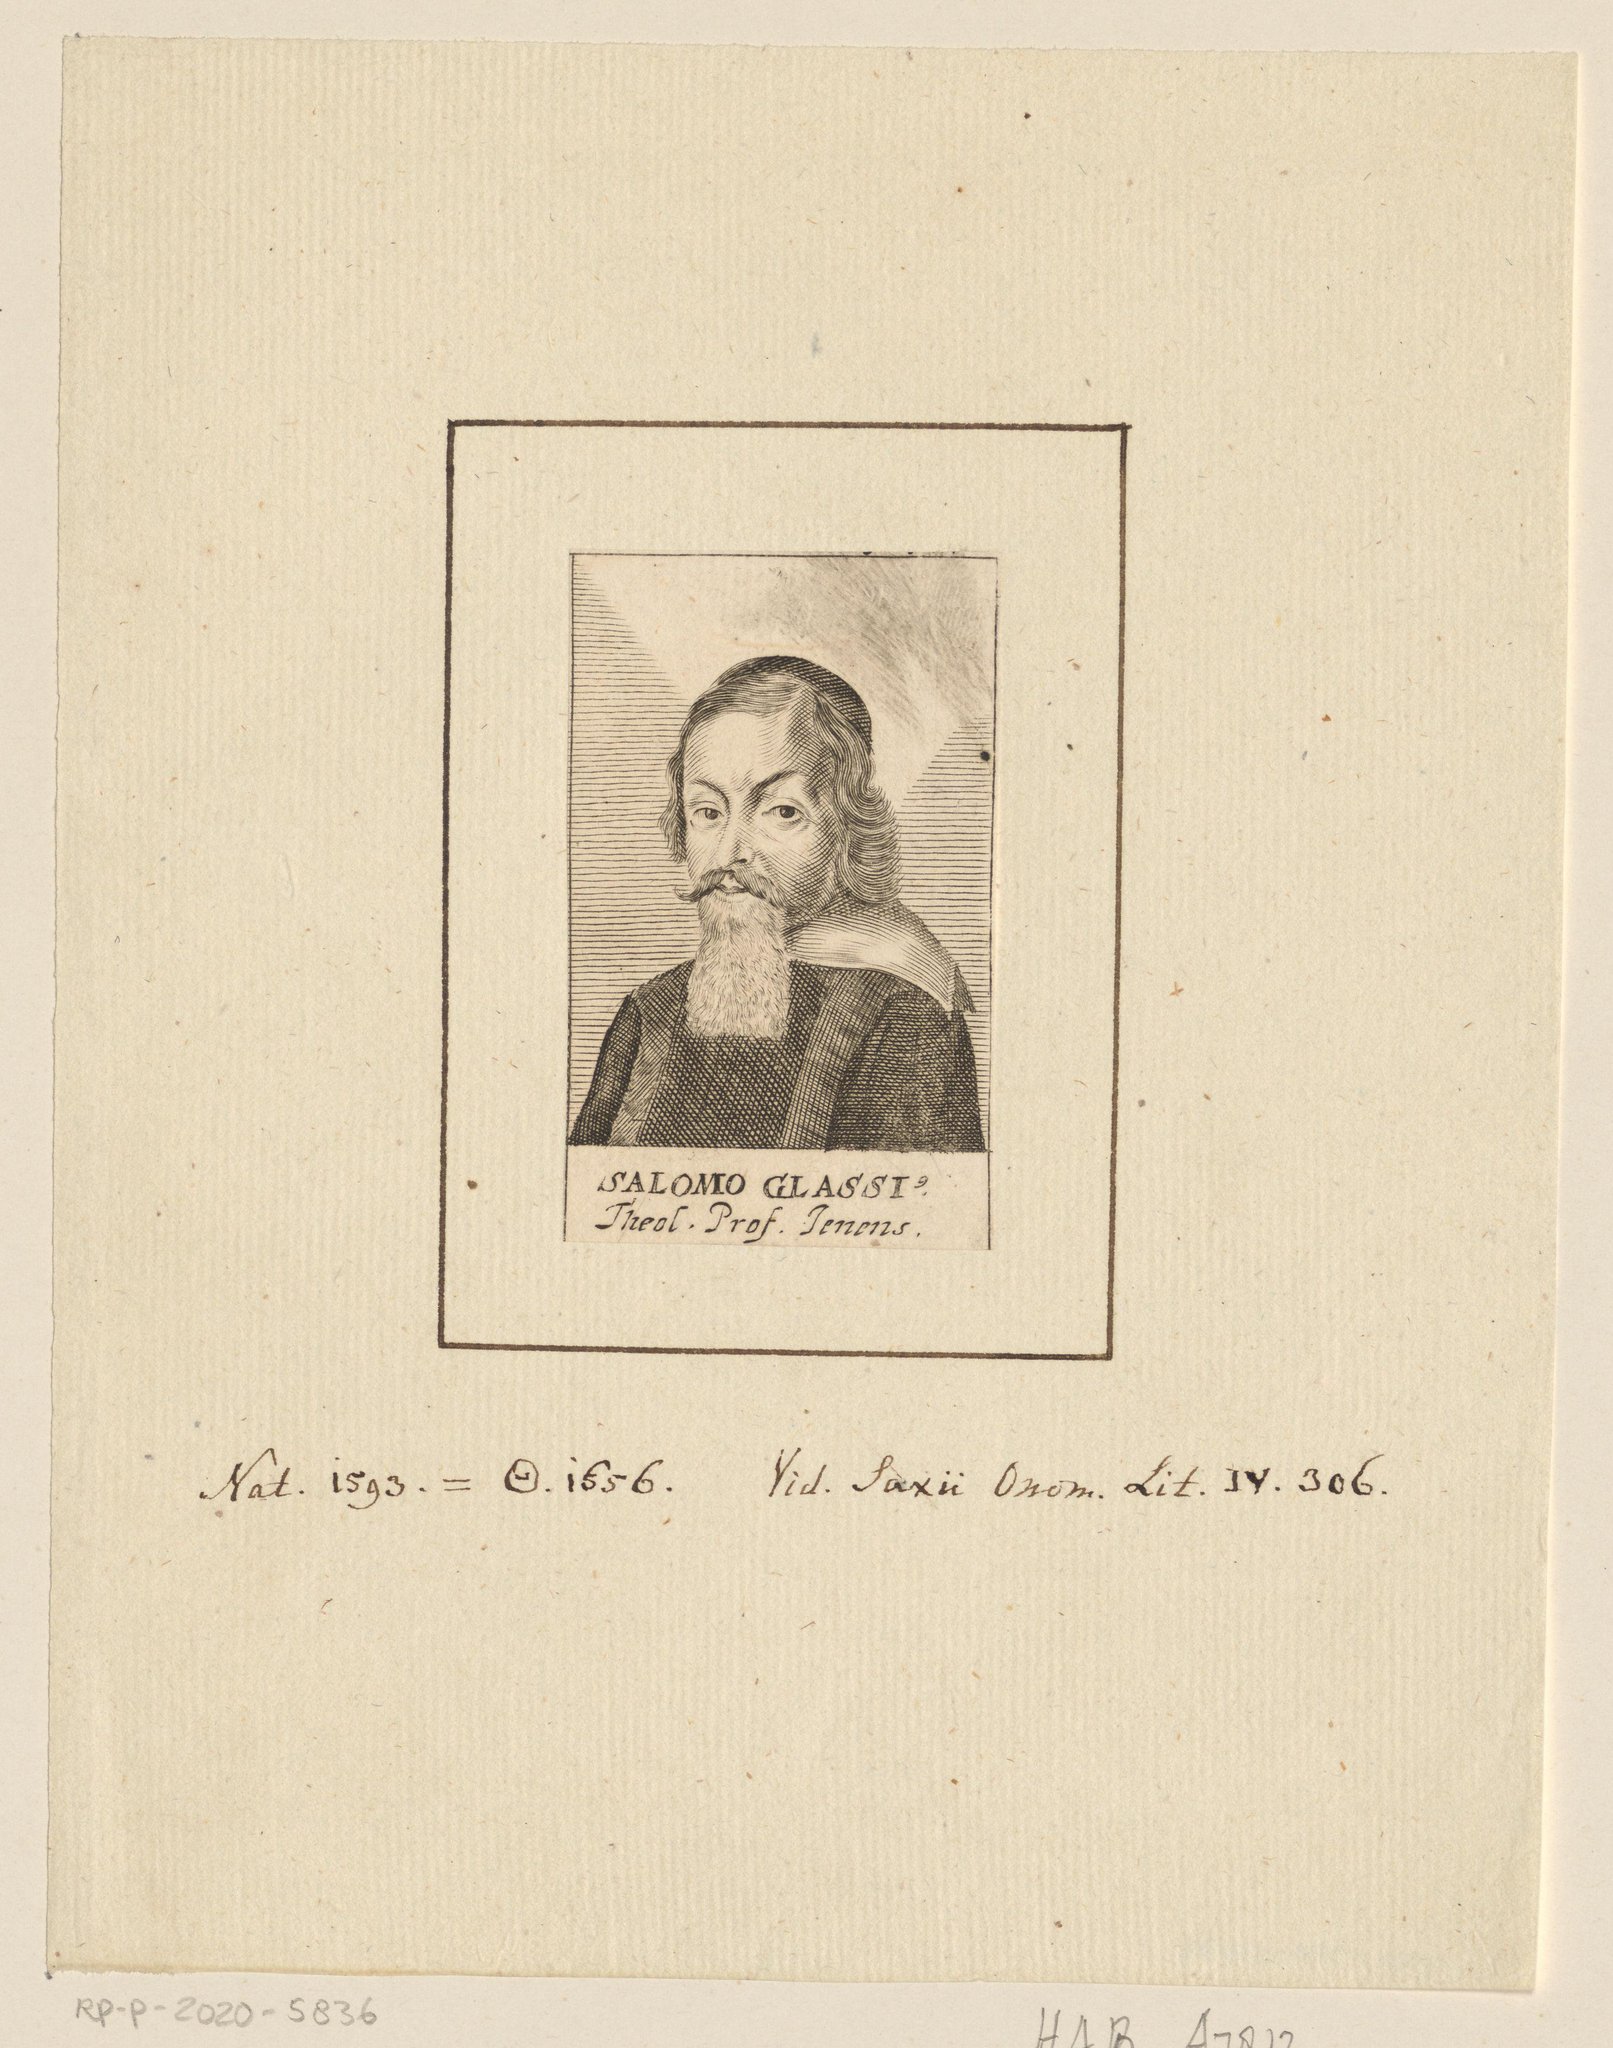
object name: book illustration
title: Portret van Salomon Glass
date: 1688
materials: paper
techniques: engraving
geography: nuremberg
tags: theologian, historical persons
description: Prent uit: Freher, Paul. Theatrum virorum eruditione clarorum. Neurenberg: Johann Hoffmann, 1688.